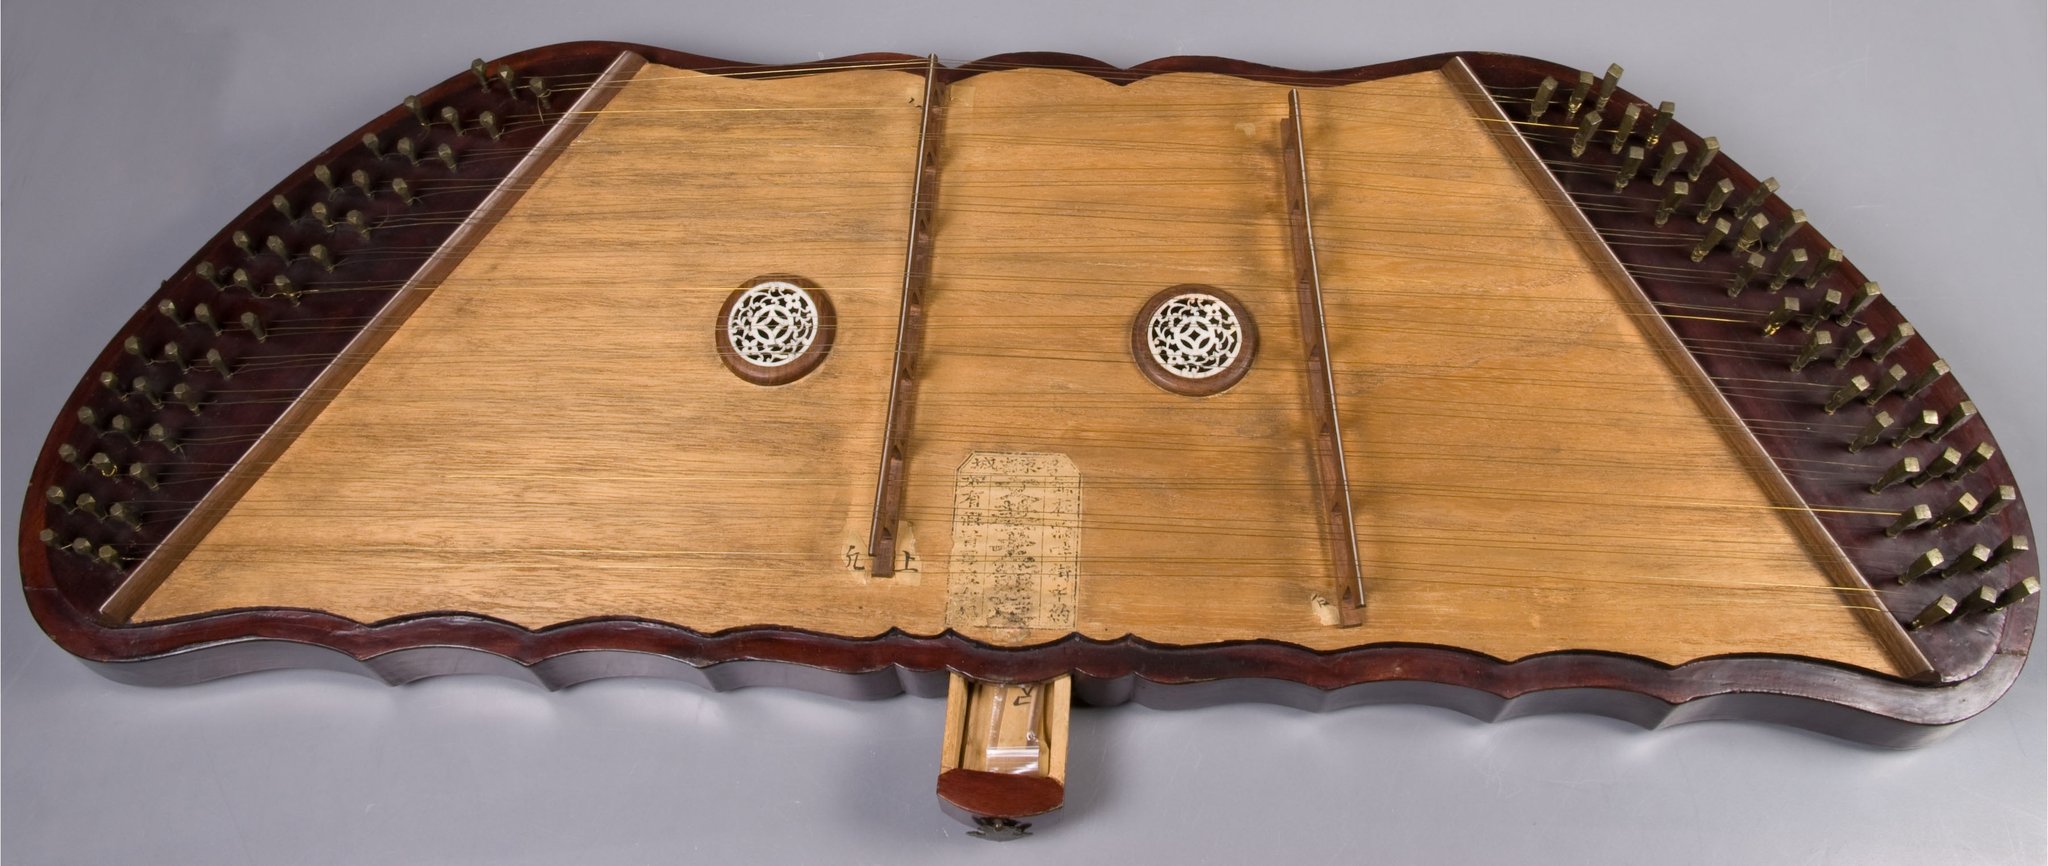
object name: yangqin 揚琴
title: Yangqin (揚琴 )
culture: chinese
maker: shop of refined tones, guangzhou (canton)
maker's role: maker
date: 1801-1900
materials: brass, wood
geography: china